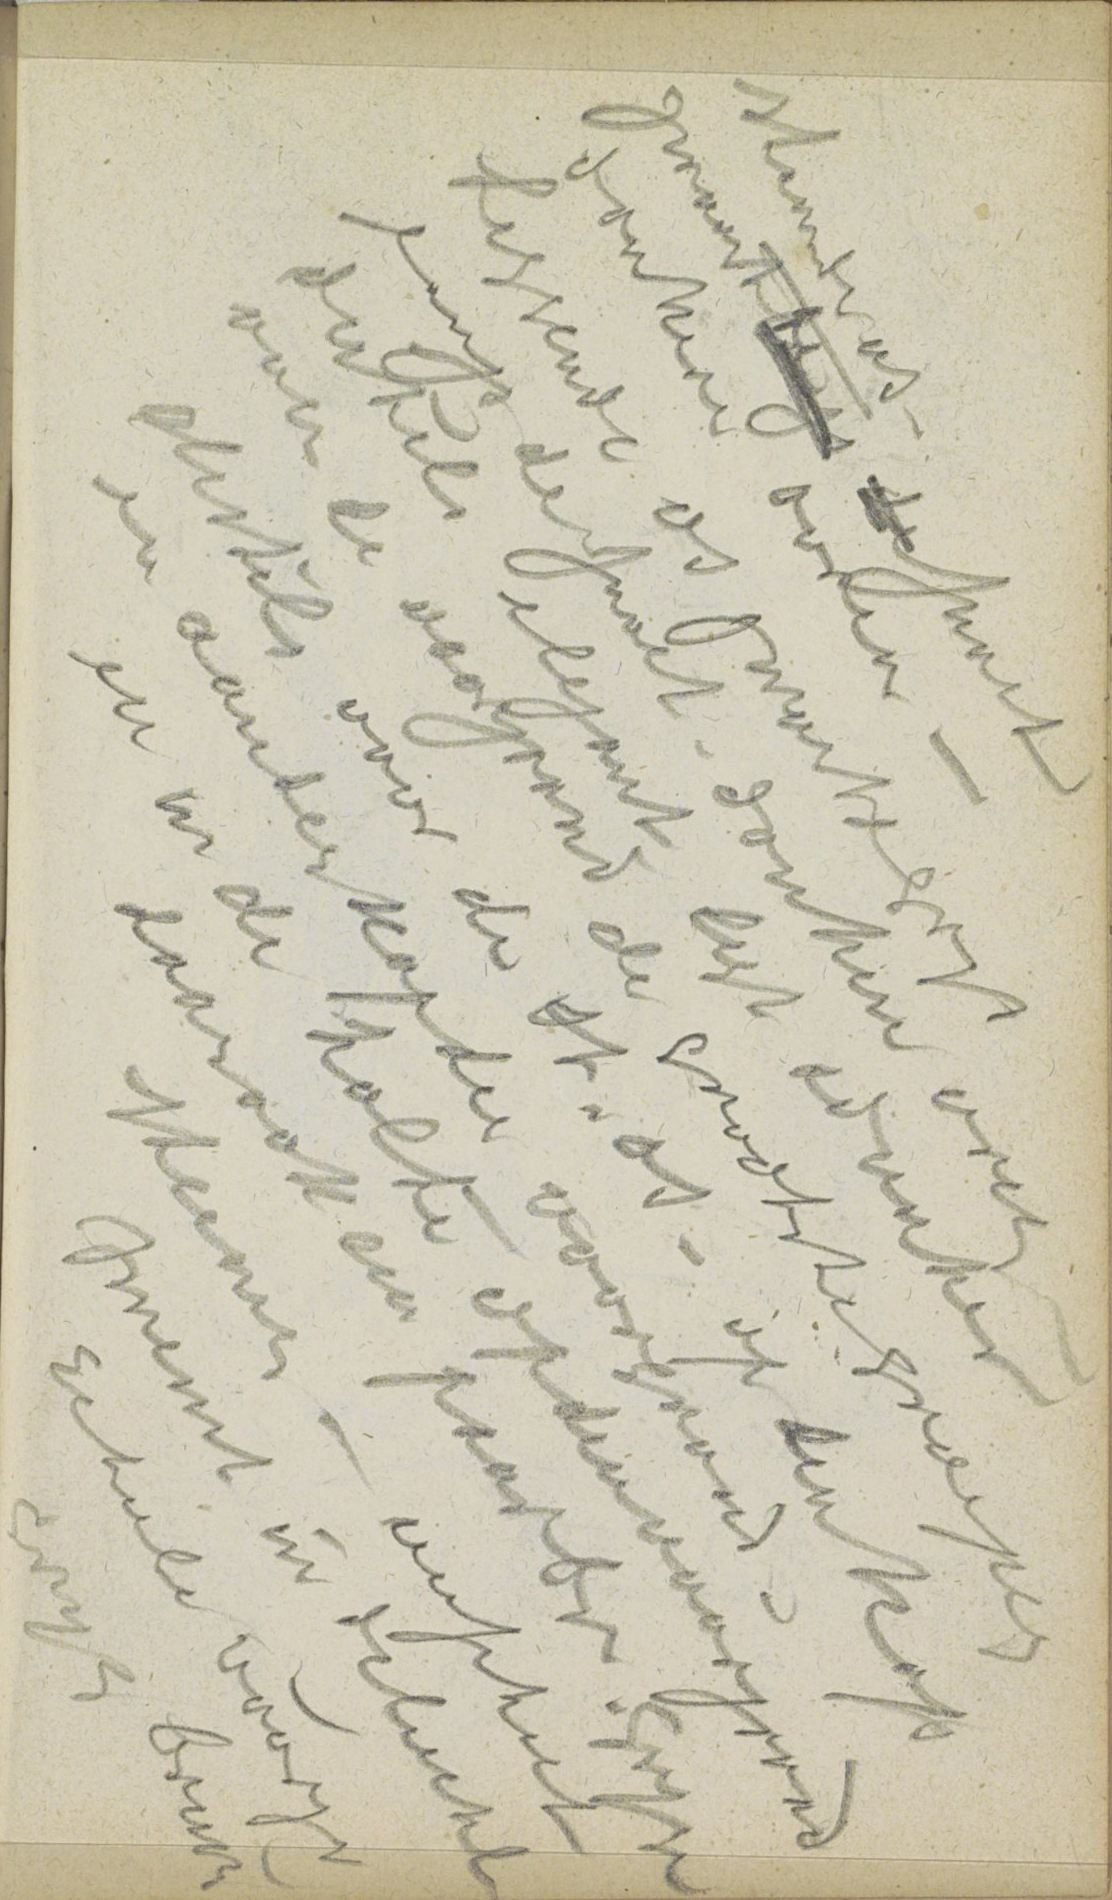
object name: sketchbook leaf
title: Beschrijving van een compositie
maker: johannes tavenraat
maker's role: draughtsman, painter, print maker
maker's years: 1809-1881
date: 1854-1868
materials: paper, pencil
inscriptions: annotation: ‘beschrijving van een compositie met o.a. een liggende os’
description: Blad 78 recto uit een schetsboek met 88 bladen.